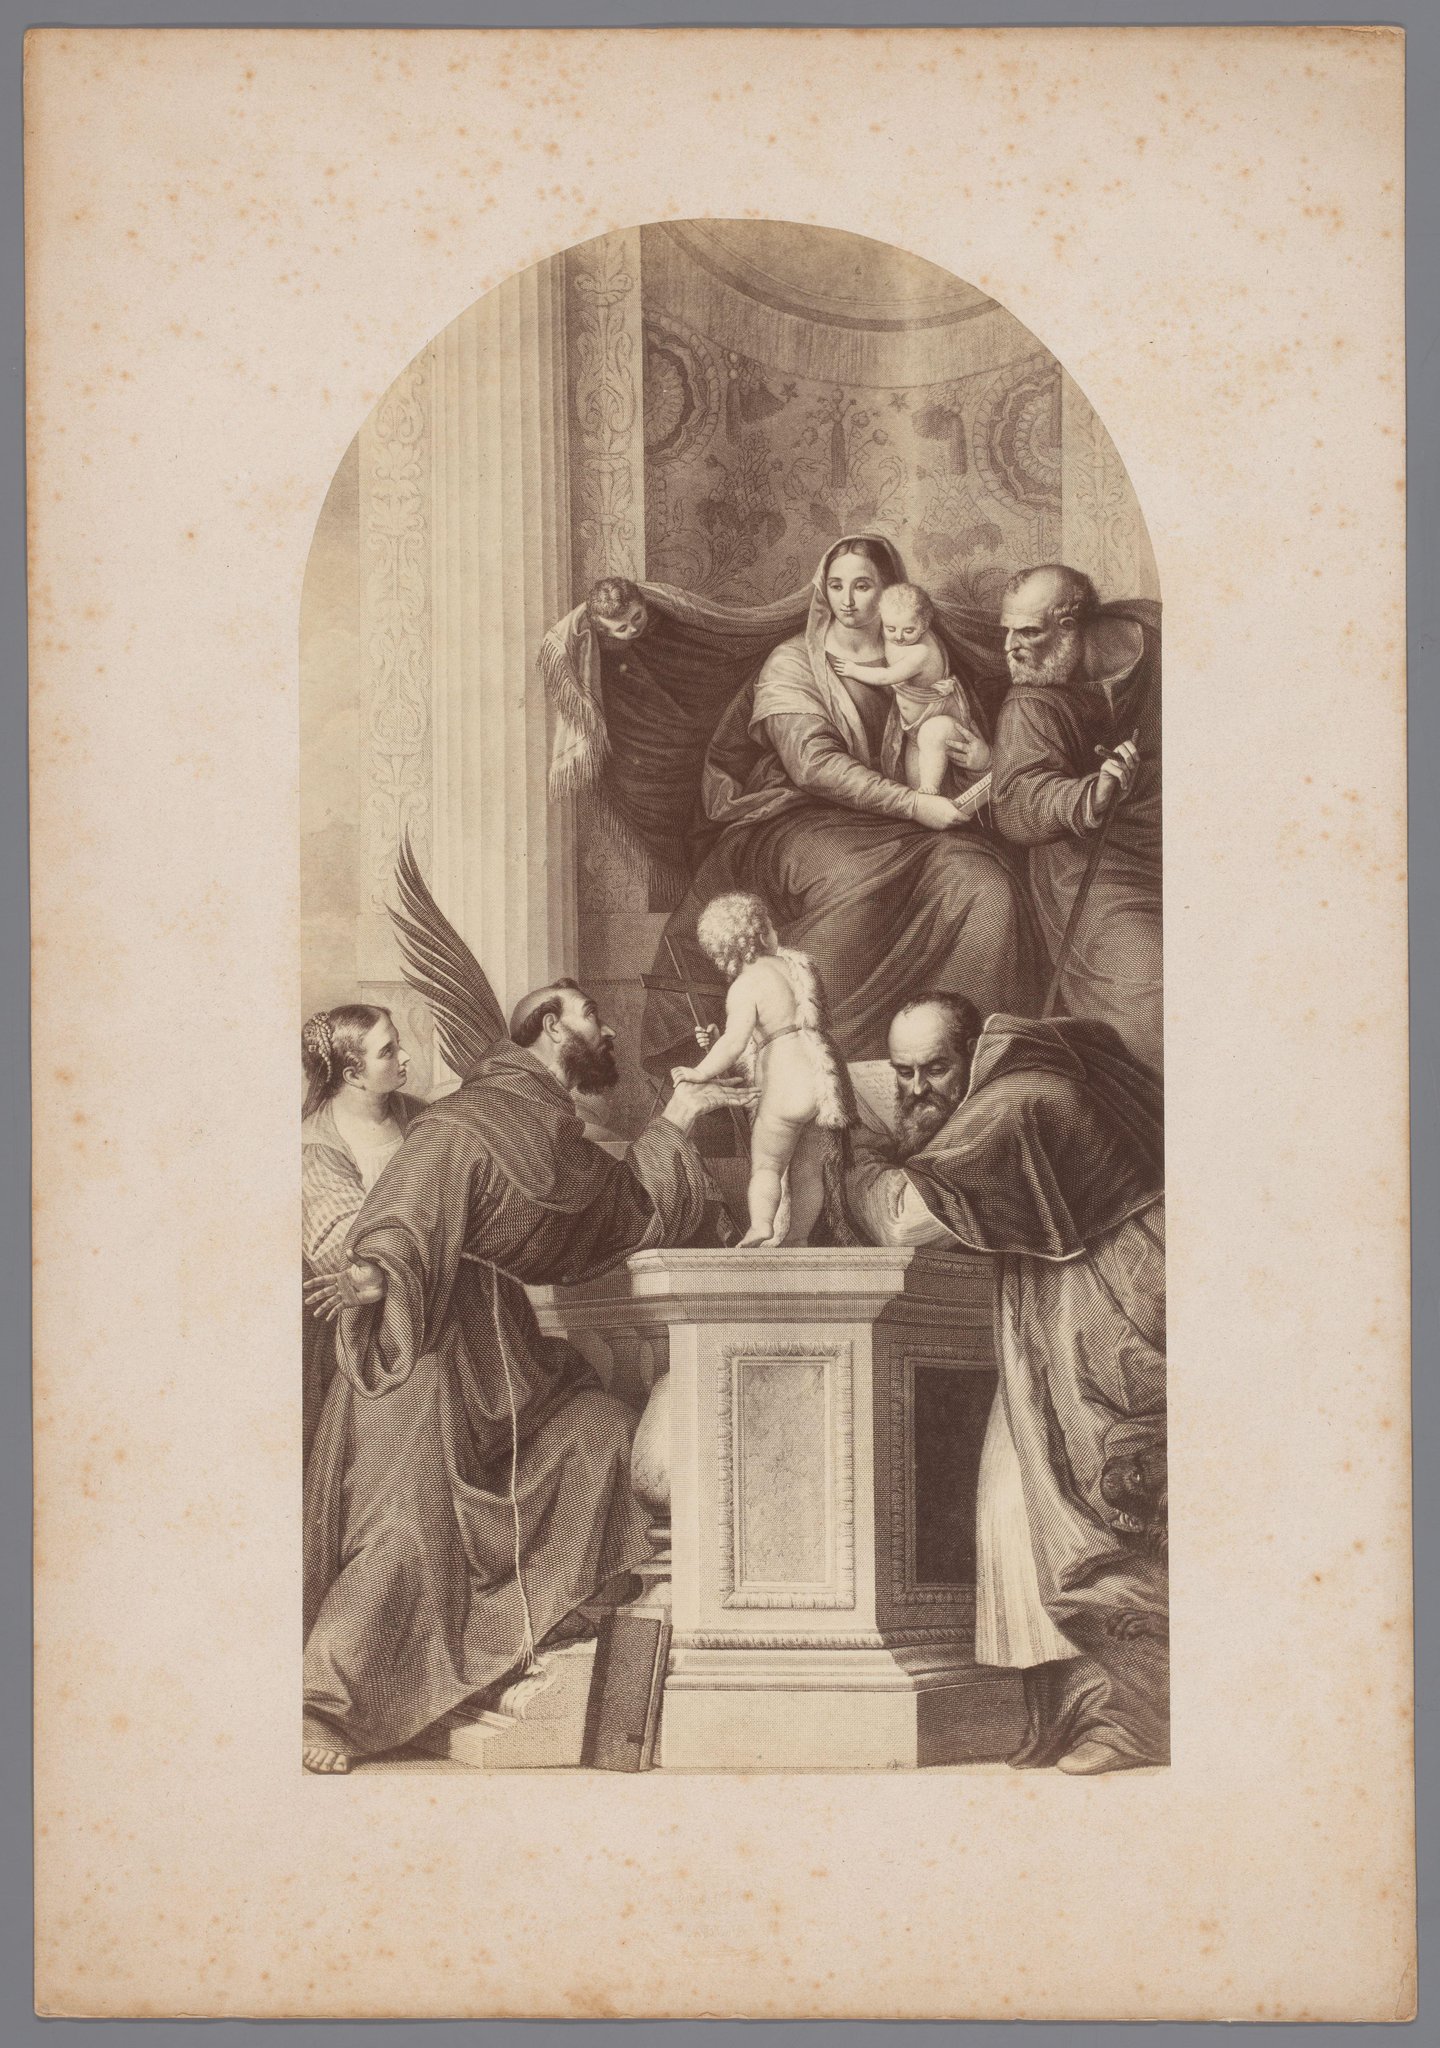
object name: reproduction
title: Madonna e Santi - P. Veronese - Accademia Venezia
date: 1852-1893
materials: cardboard, paper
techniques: albumen print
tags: madonna: i.e. mary with the christ-child, printing ~ applied arts